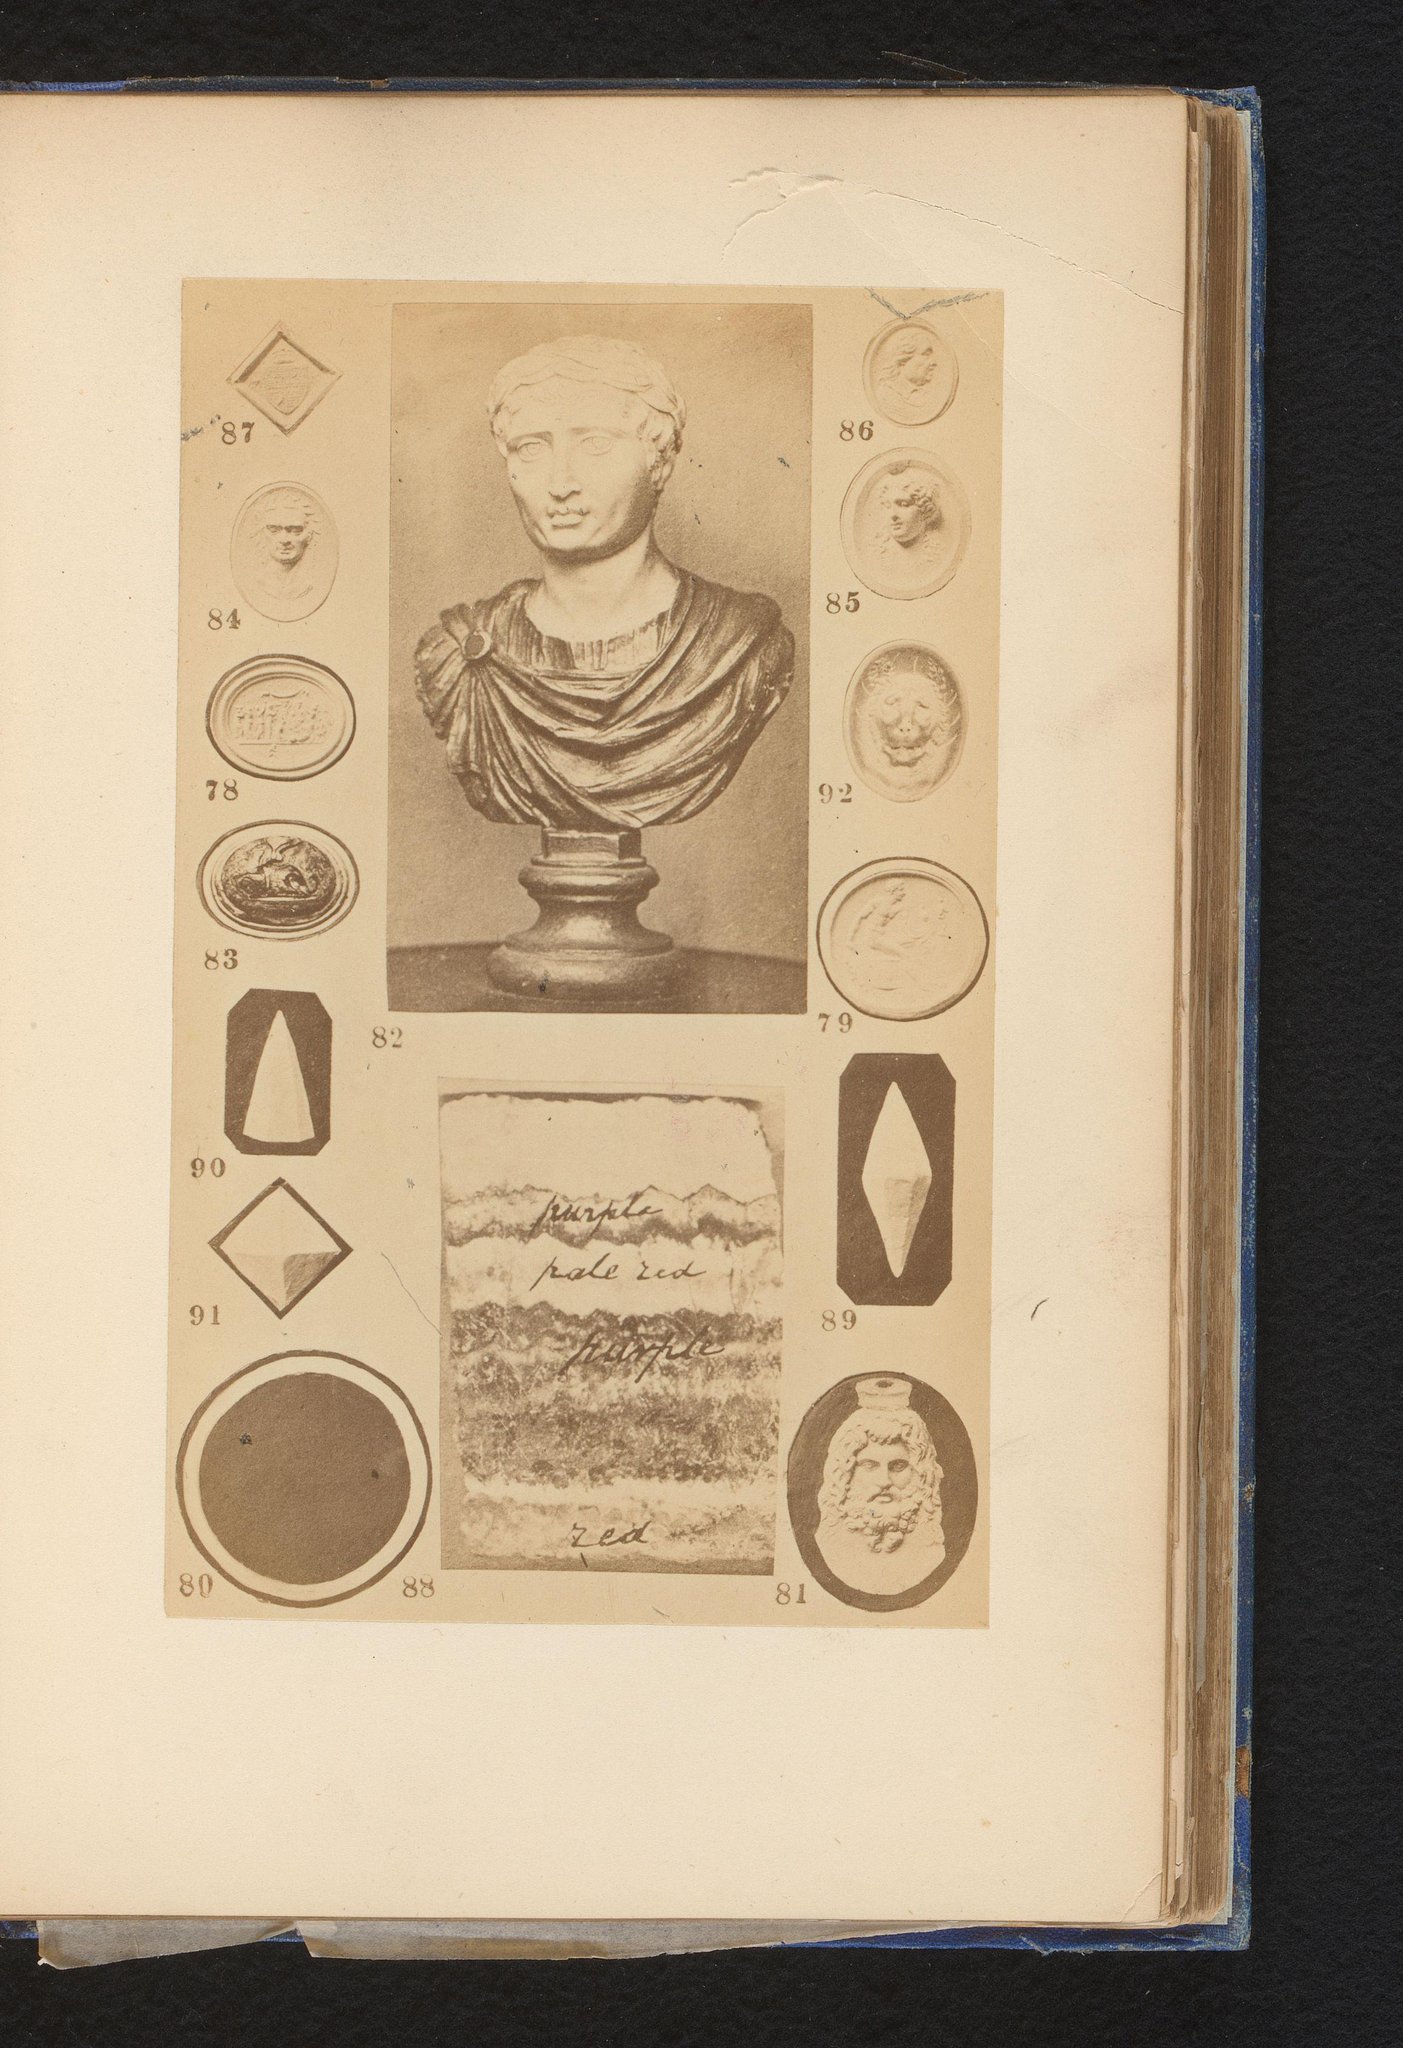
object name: photograph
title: Dertien reliëfs en een buste van keizer Claudius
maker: f. cole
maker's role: fotograaf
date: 1862-1867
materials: paper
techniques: albumen print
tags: sculpture, (story of) claudius the roman emperor, sculpture (+ relief ~ sculpture)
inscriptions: number: ‘78 - 92’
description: Foto op derde ongenummerde pagina na pagina 92.